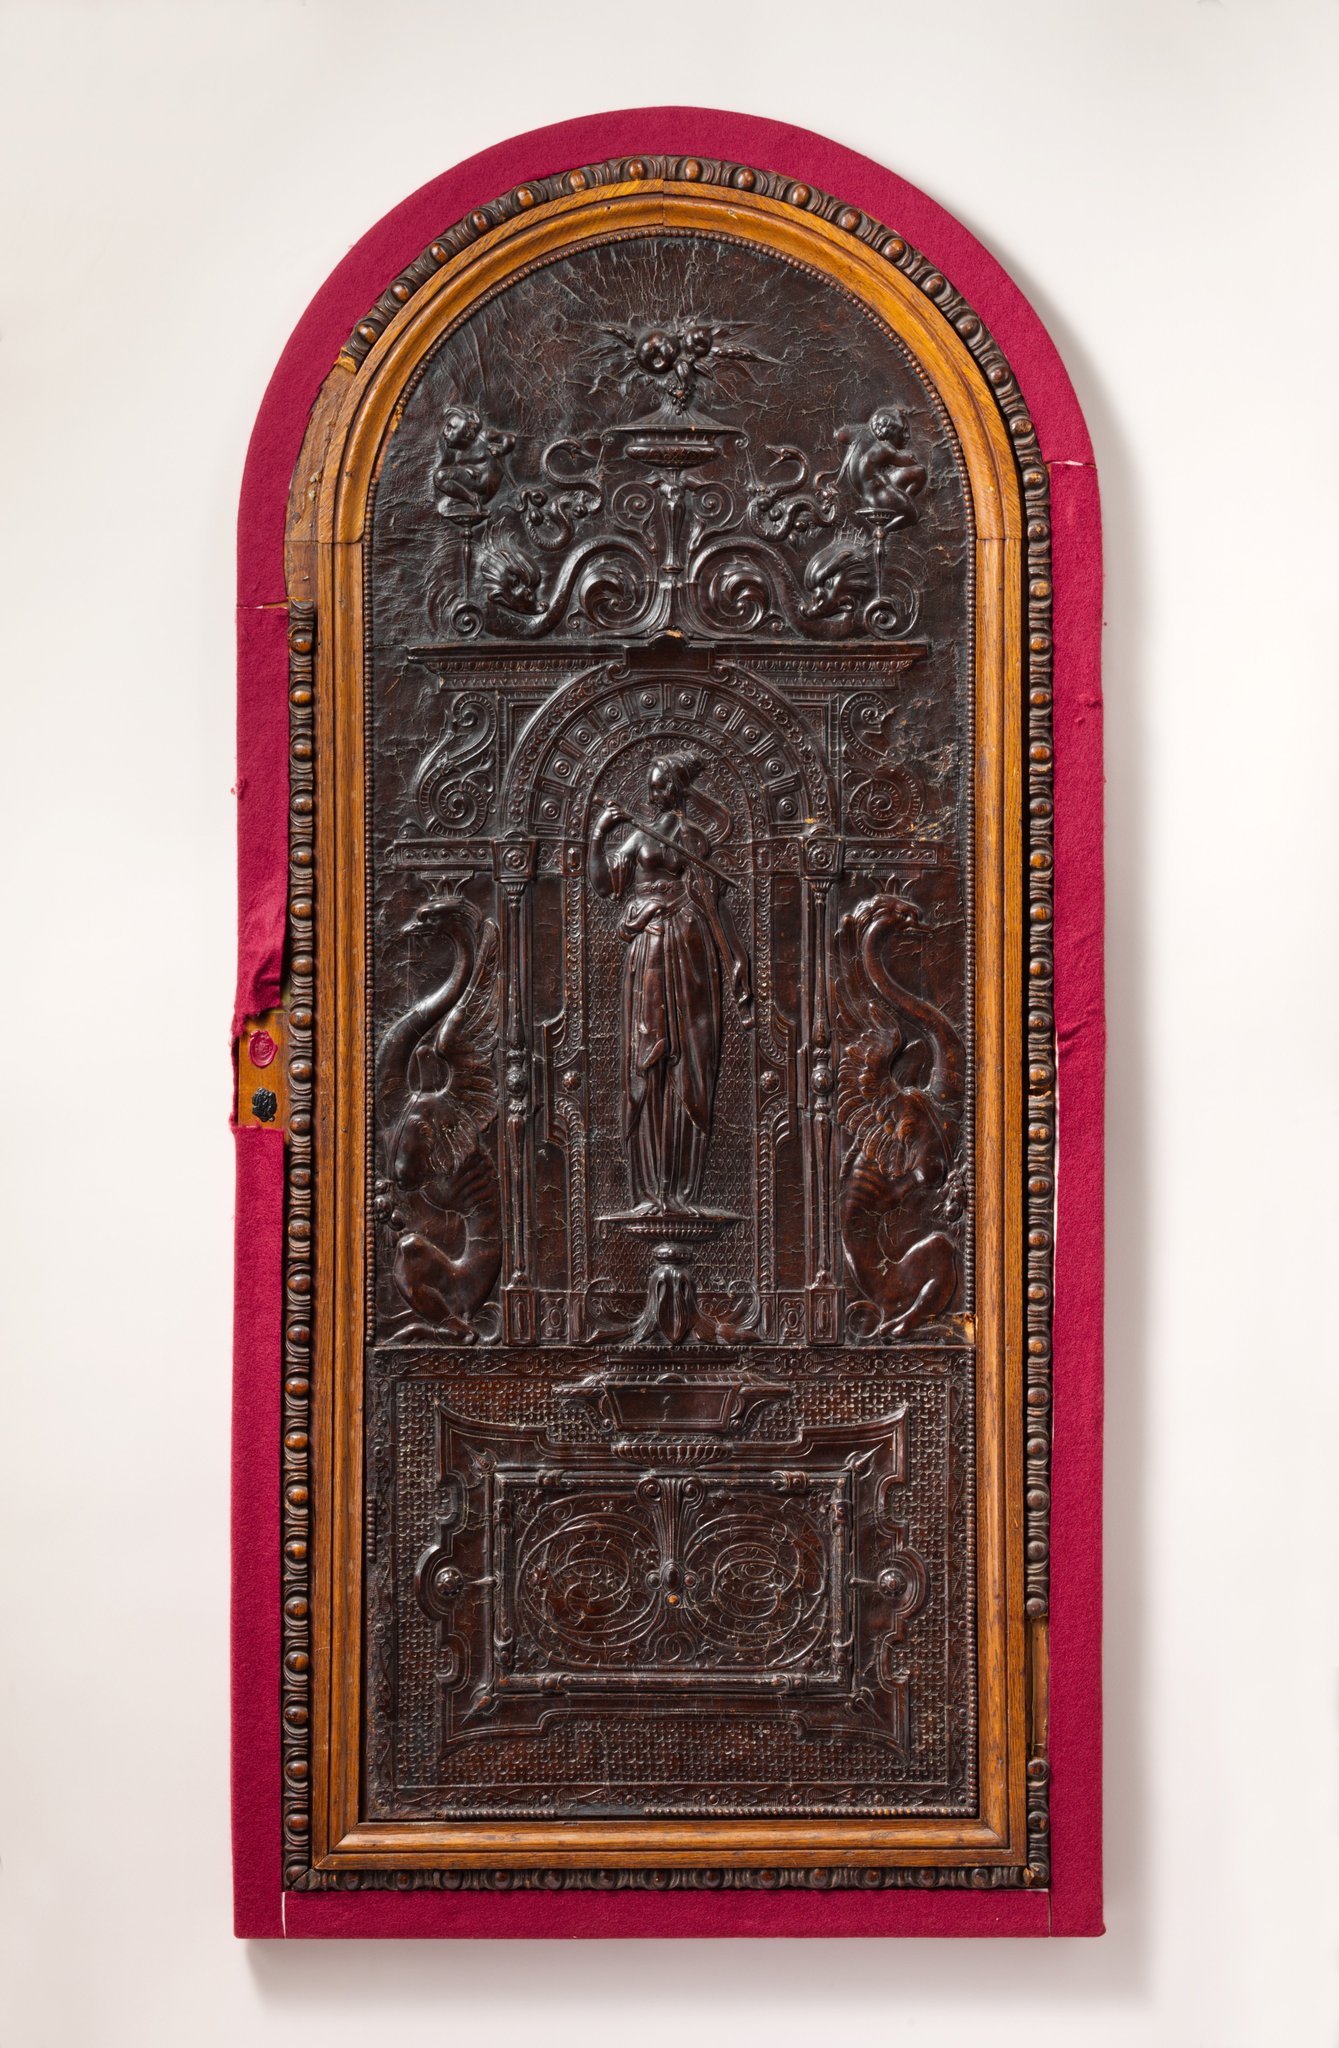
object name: panel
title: Allegory of Music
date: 1570-1590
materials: leather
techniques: embossing, incising, molding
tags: musical instruments,women,mythical creatures,allegory